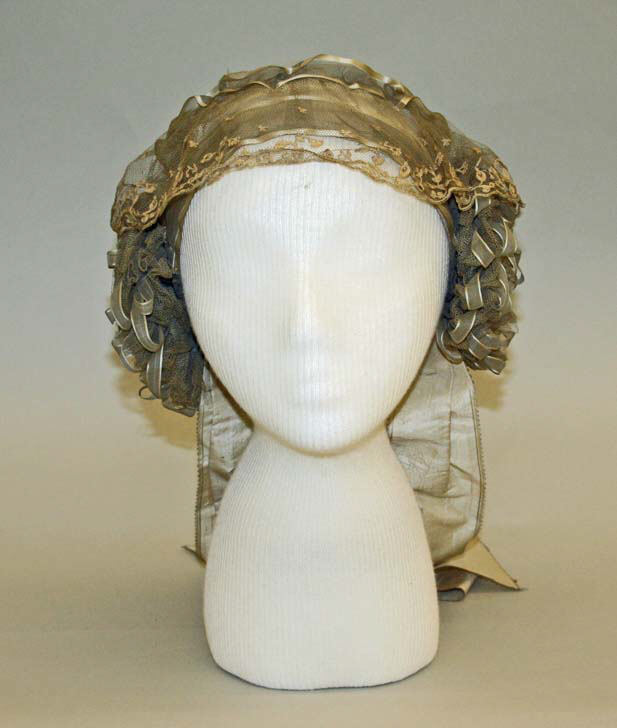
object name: bonnet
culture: european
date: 1799-1815